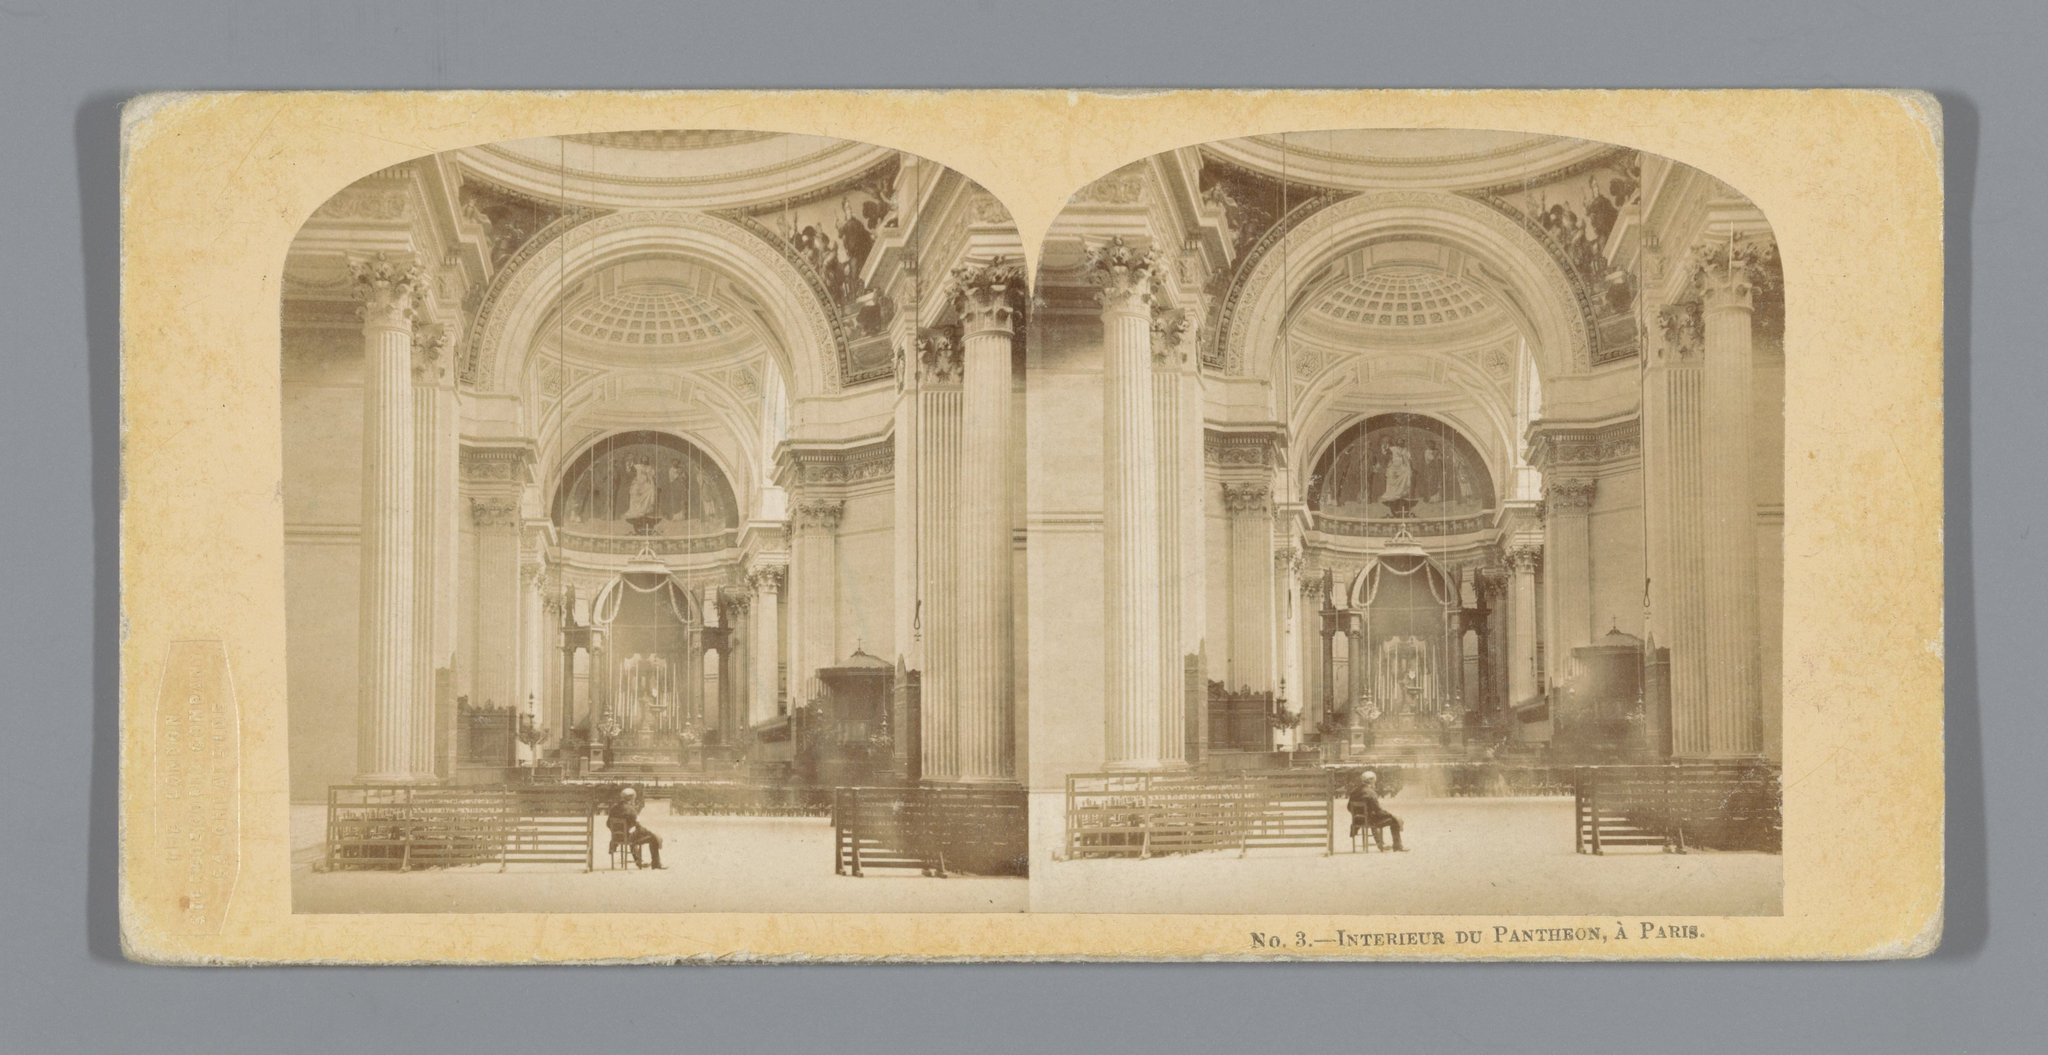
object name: stereograph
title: Interieur du Pantheon, à Paris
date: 1850-1875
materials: cardboard, photographic support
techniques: albumen print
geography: pantheon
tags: interior of church, interior ~ representation of a building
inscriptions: number: ‘No. 3.’